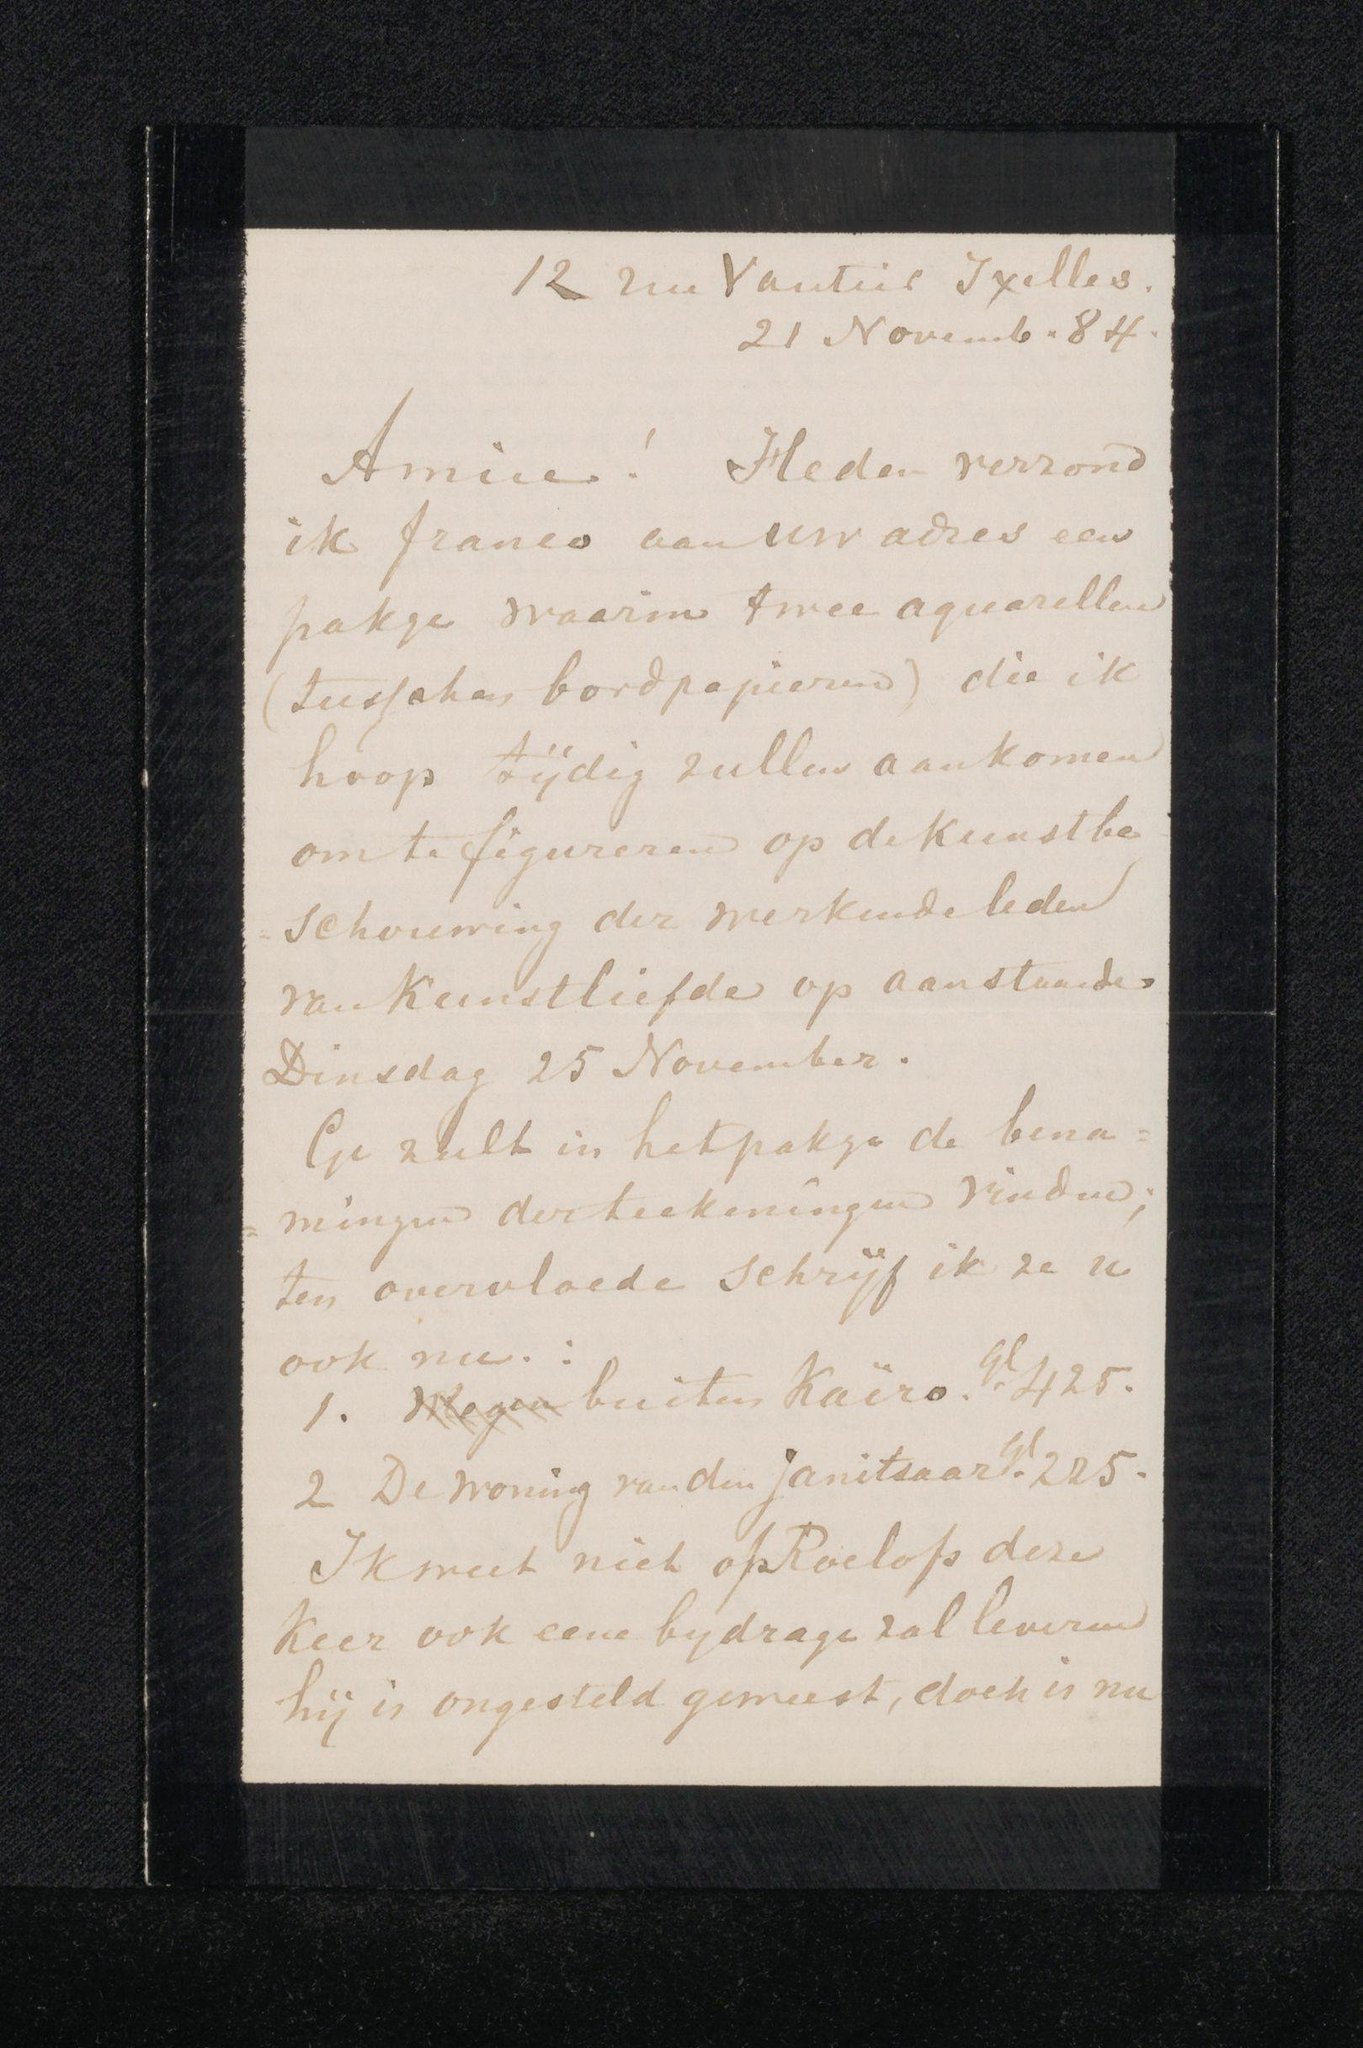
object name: letter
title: Brief aan anoniem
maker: willem de famars testas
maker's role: draughtsman, painter, print maker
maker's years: 1834-1896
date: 1884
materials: ink, paper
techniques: pen, writing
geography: elsene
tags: willem roelofs (i), criticizing and discussing art, art criticism, drawing, family life, exhibition ~ art, money, brussels, utrecht